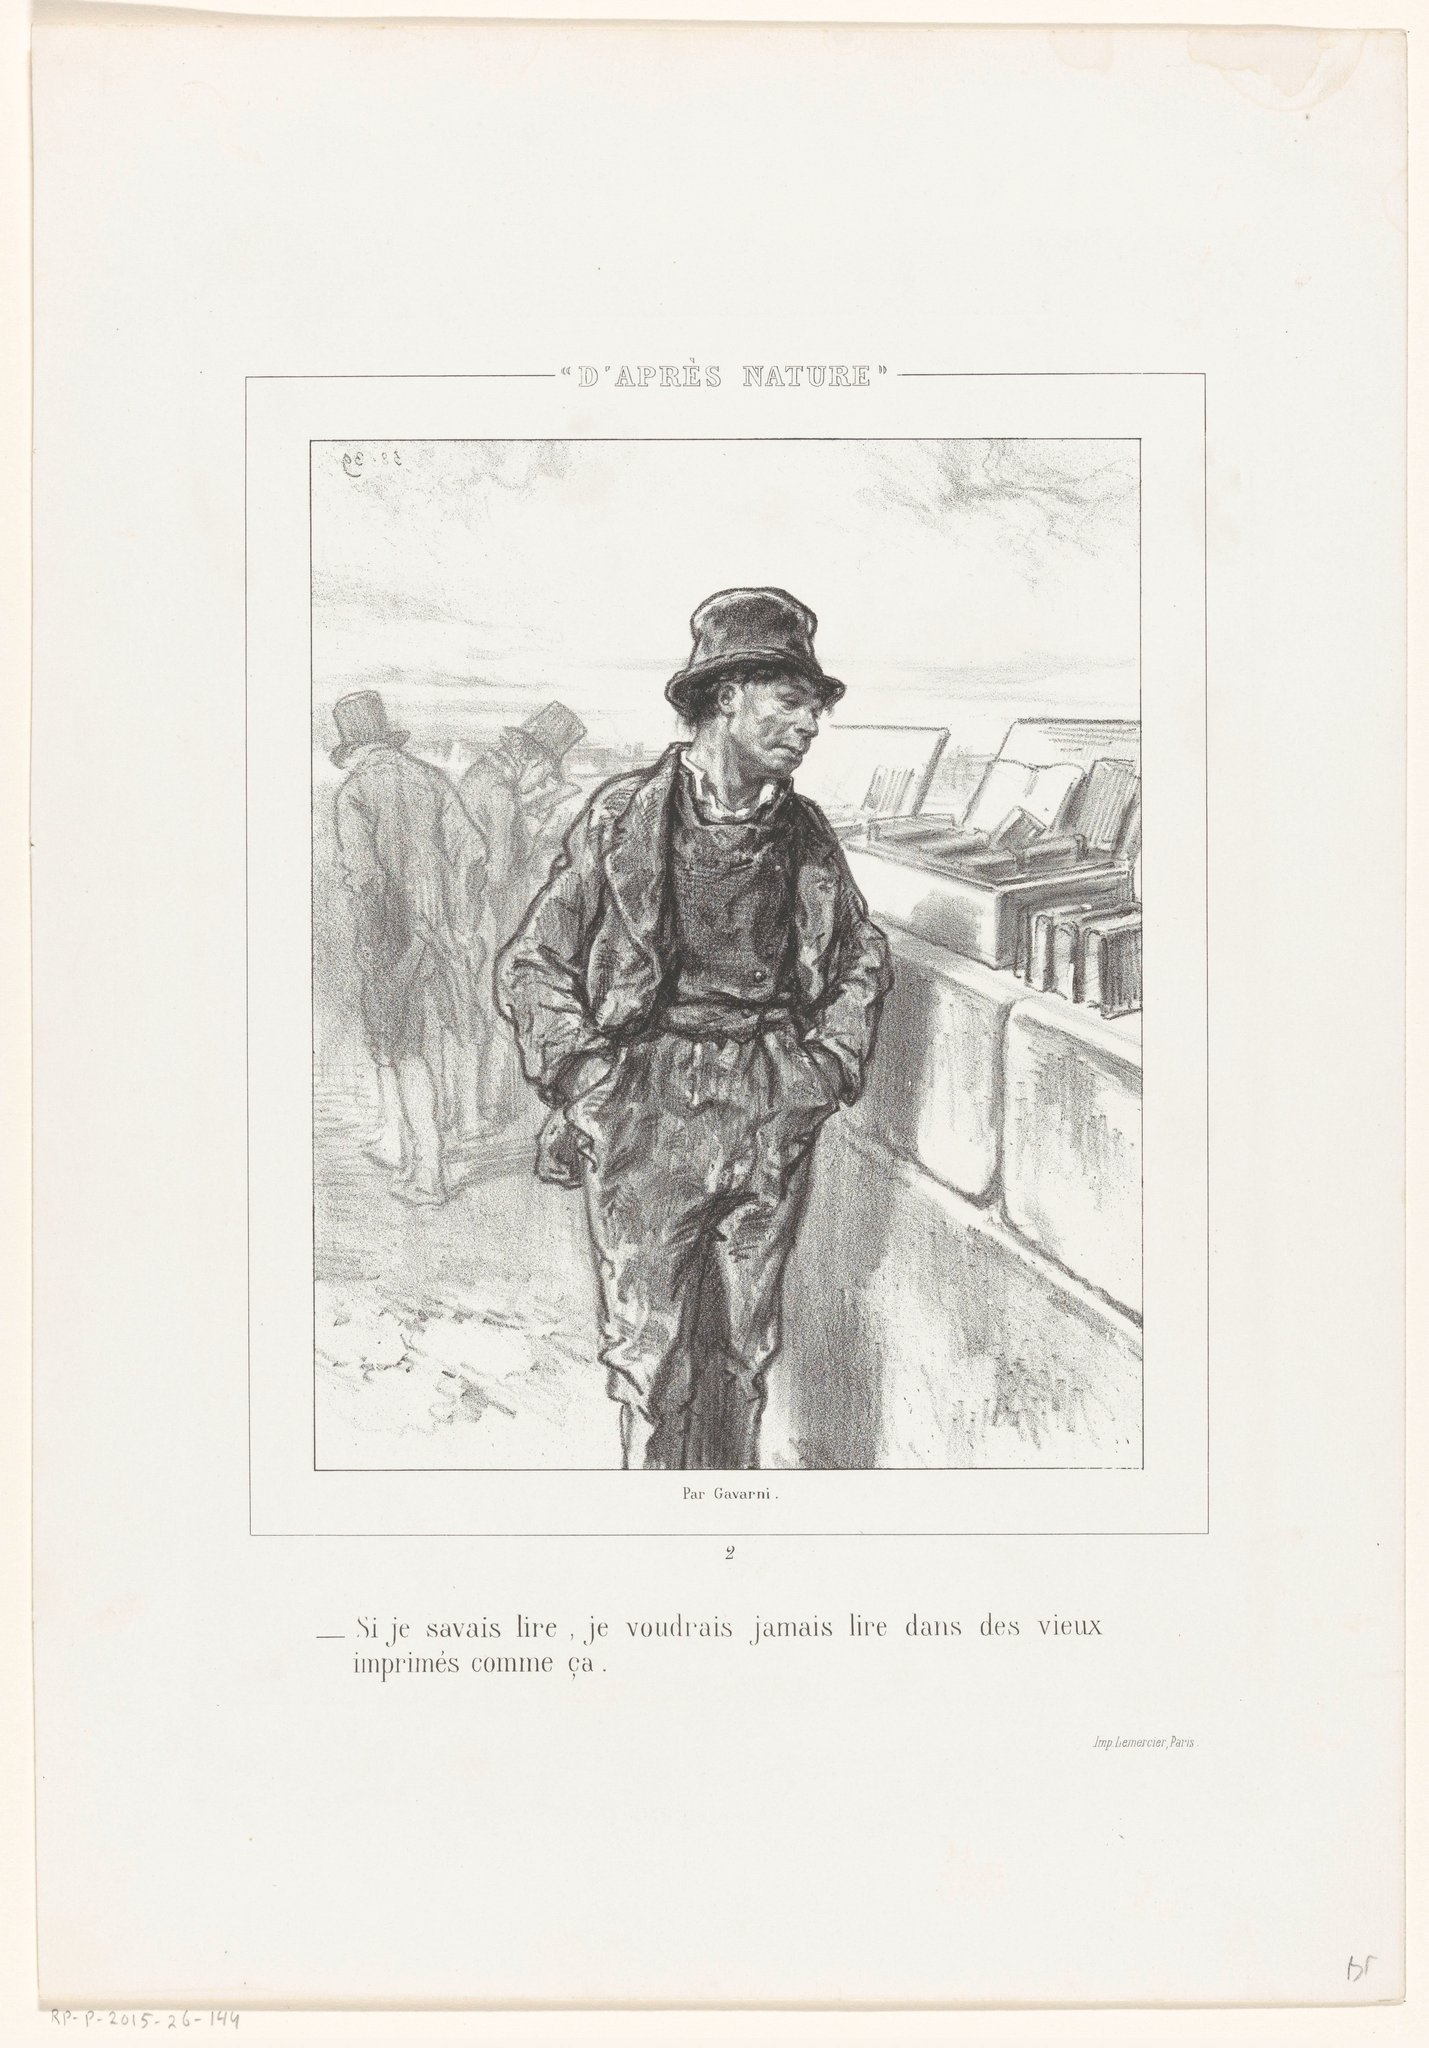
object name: print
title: Naar de natuur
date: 1858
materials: paper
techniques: lithograph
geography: paris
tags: book-stall, kiosk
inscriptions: collector's mark: Lugt 2228, collector's mark: Lugt 4780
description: De ongeletterde man kijkt afkeurend naar oude boeken. Midden onder genummerd: 2.